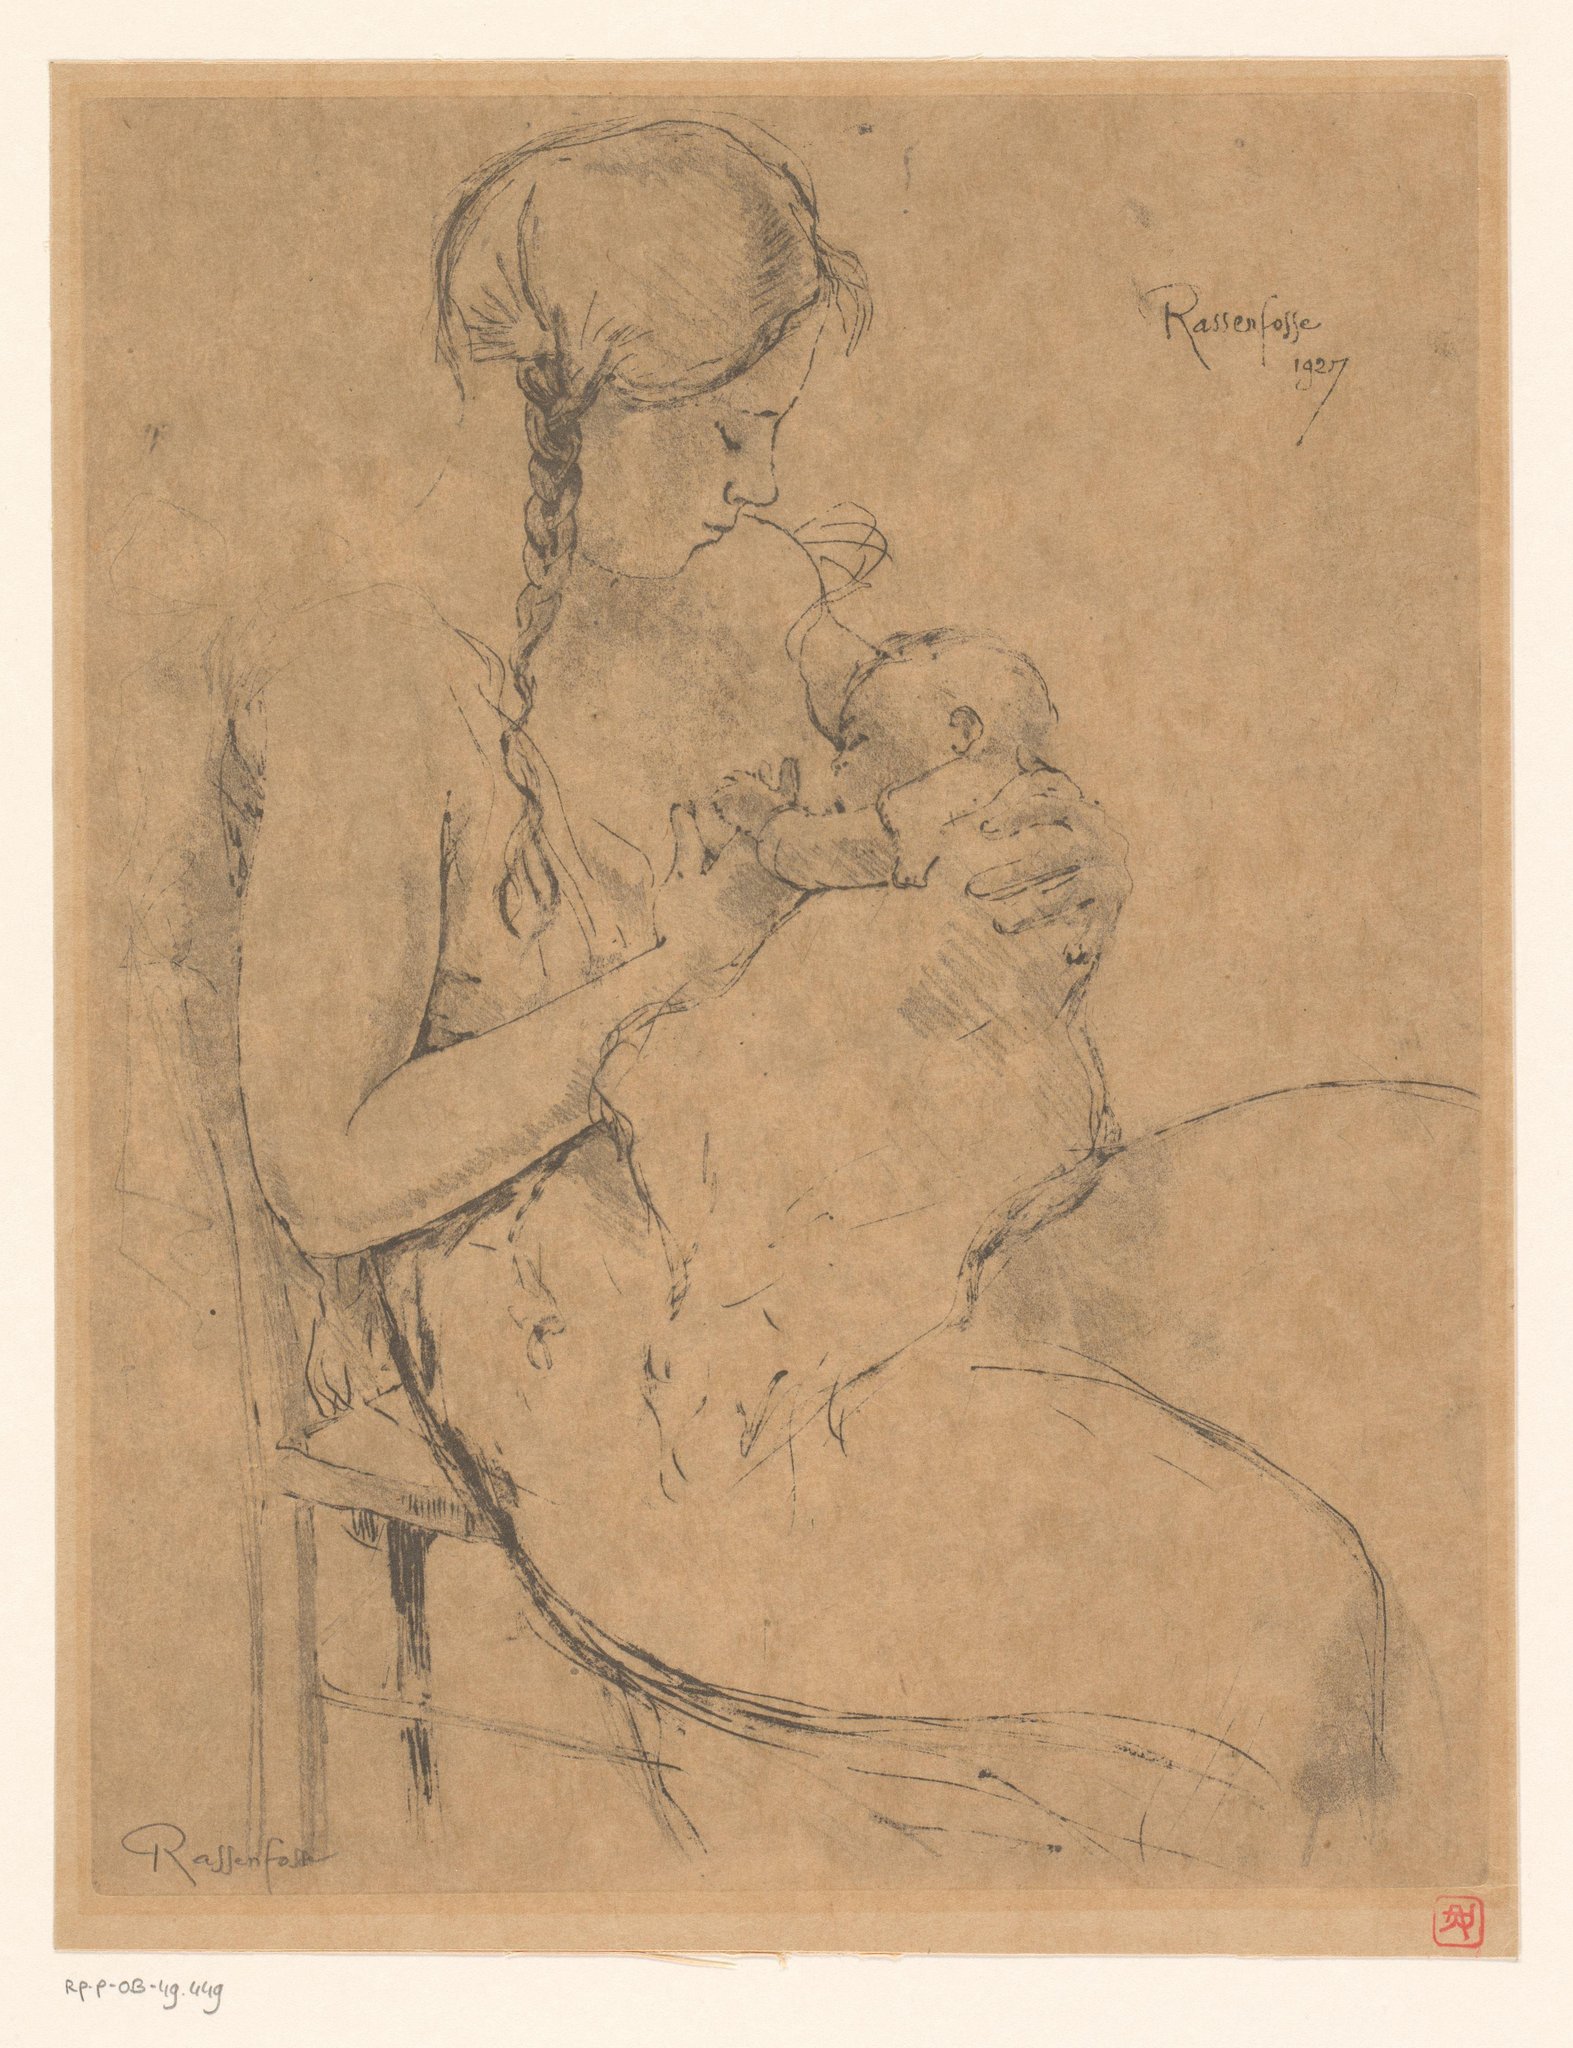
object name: print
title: Jonge vrouw met vlechten geeft een kind borstvoeding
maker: armand rassenfosse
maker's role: draughtsman, painter, print maker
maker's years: 1862-1934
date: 1927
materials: paper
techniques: drypoint, soft ground etching, sugar lift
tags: adolescent, young woman, maiden, feeding a baby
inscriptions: monogram: Lugt 169, collector's mark: Lugt 2228